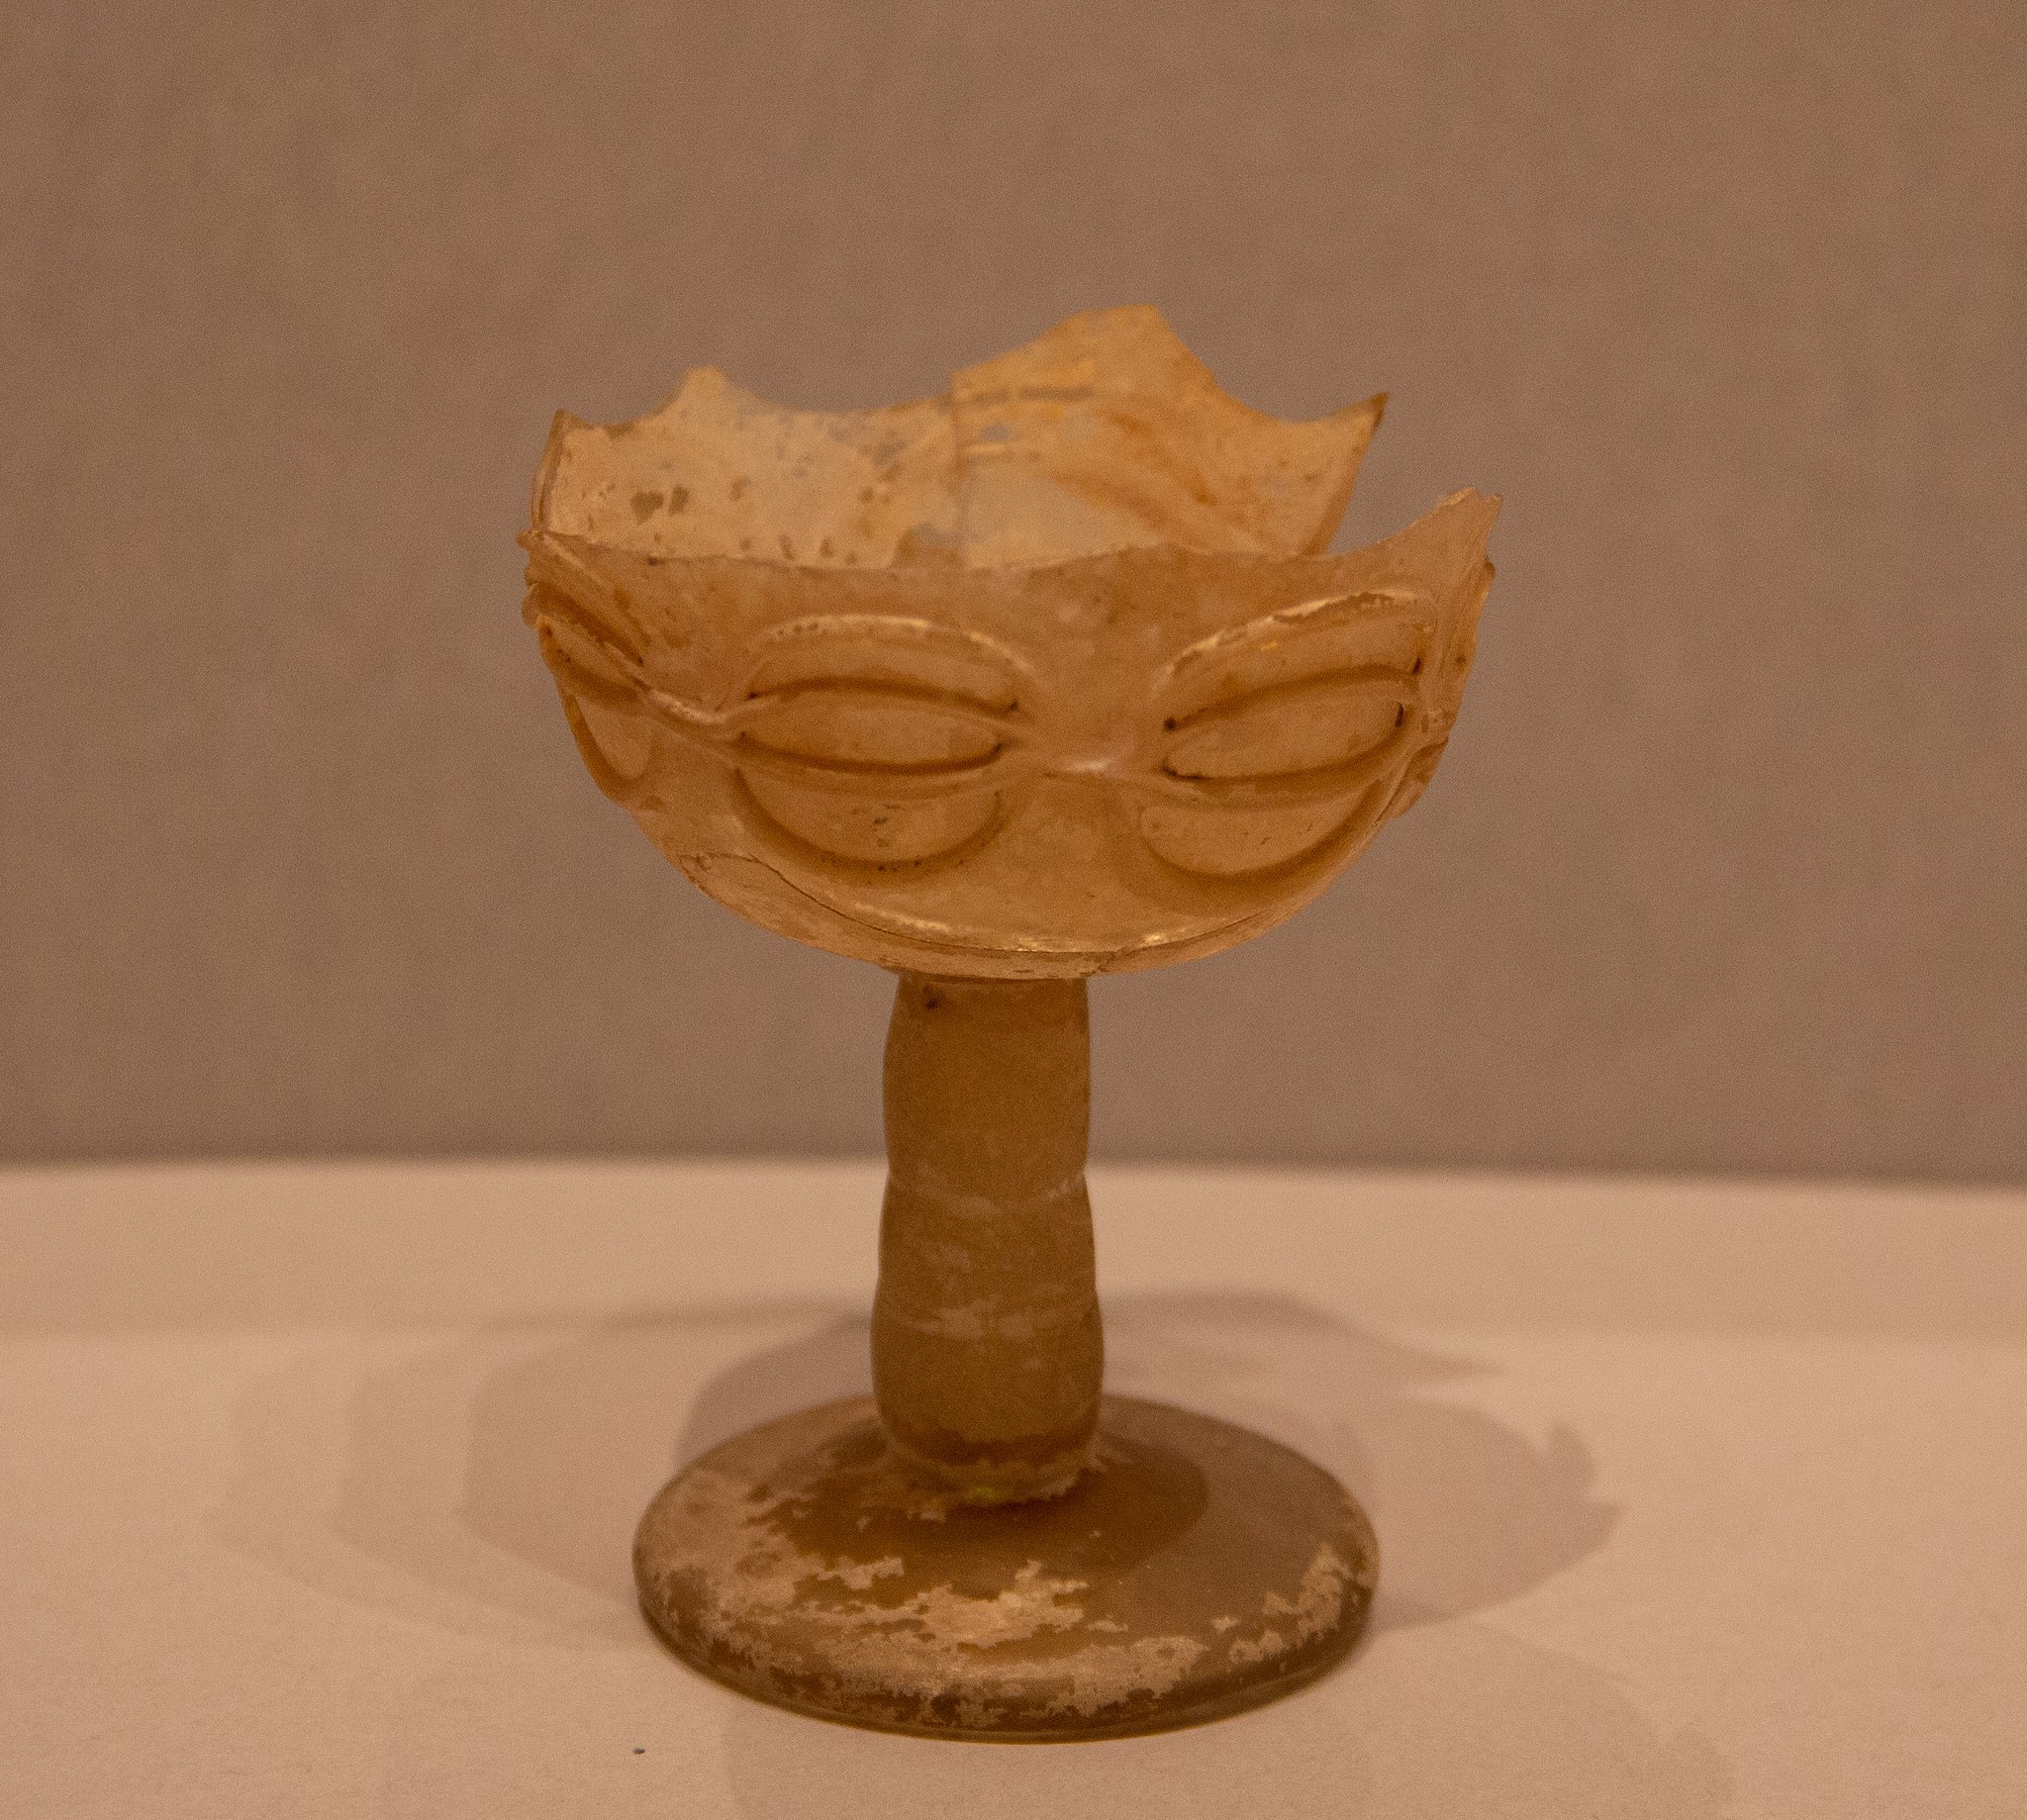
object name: goblet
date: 801-1000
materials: glass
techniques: glassblowing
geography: iran